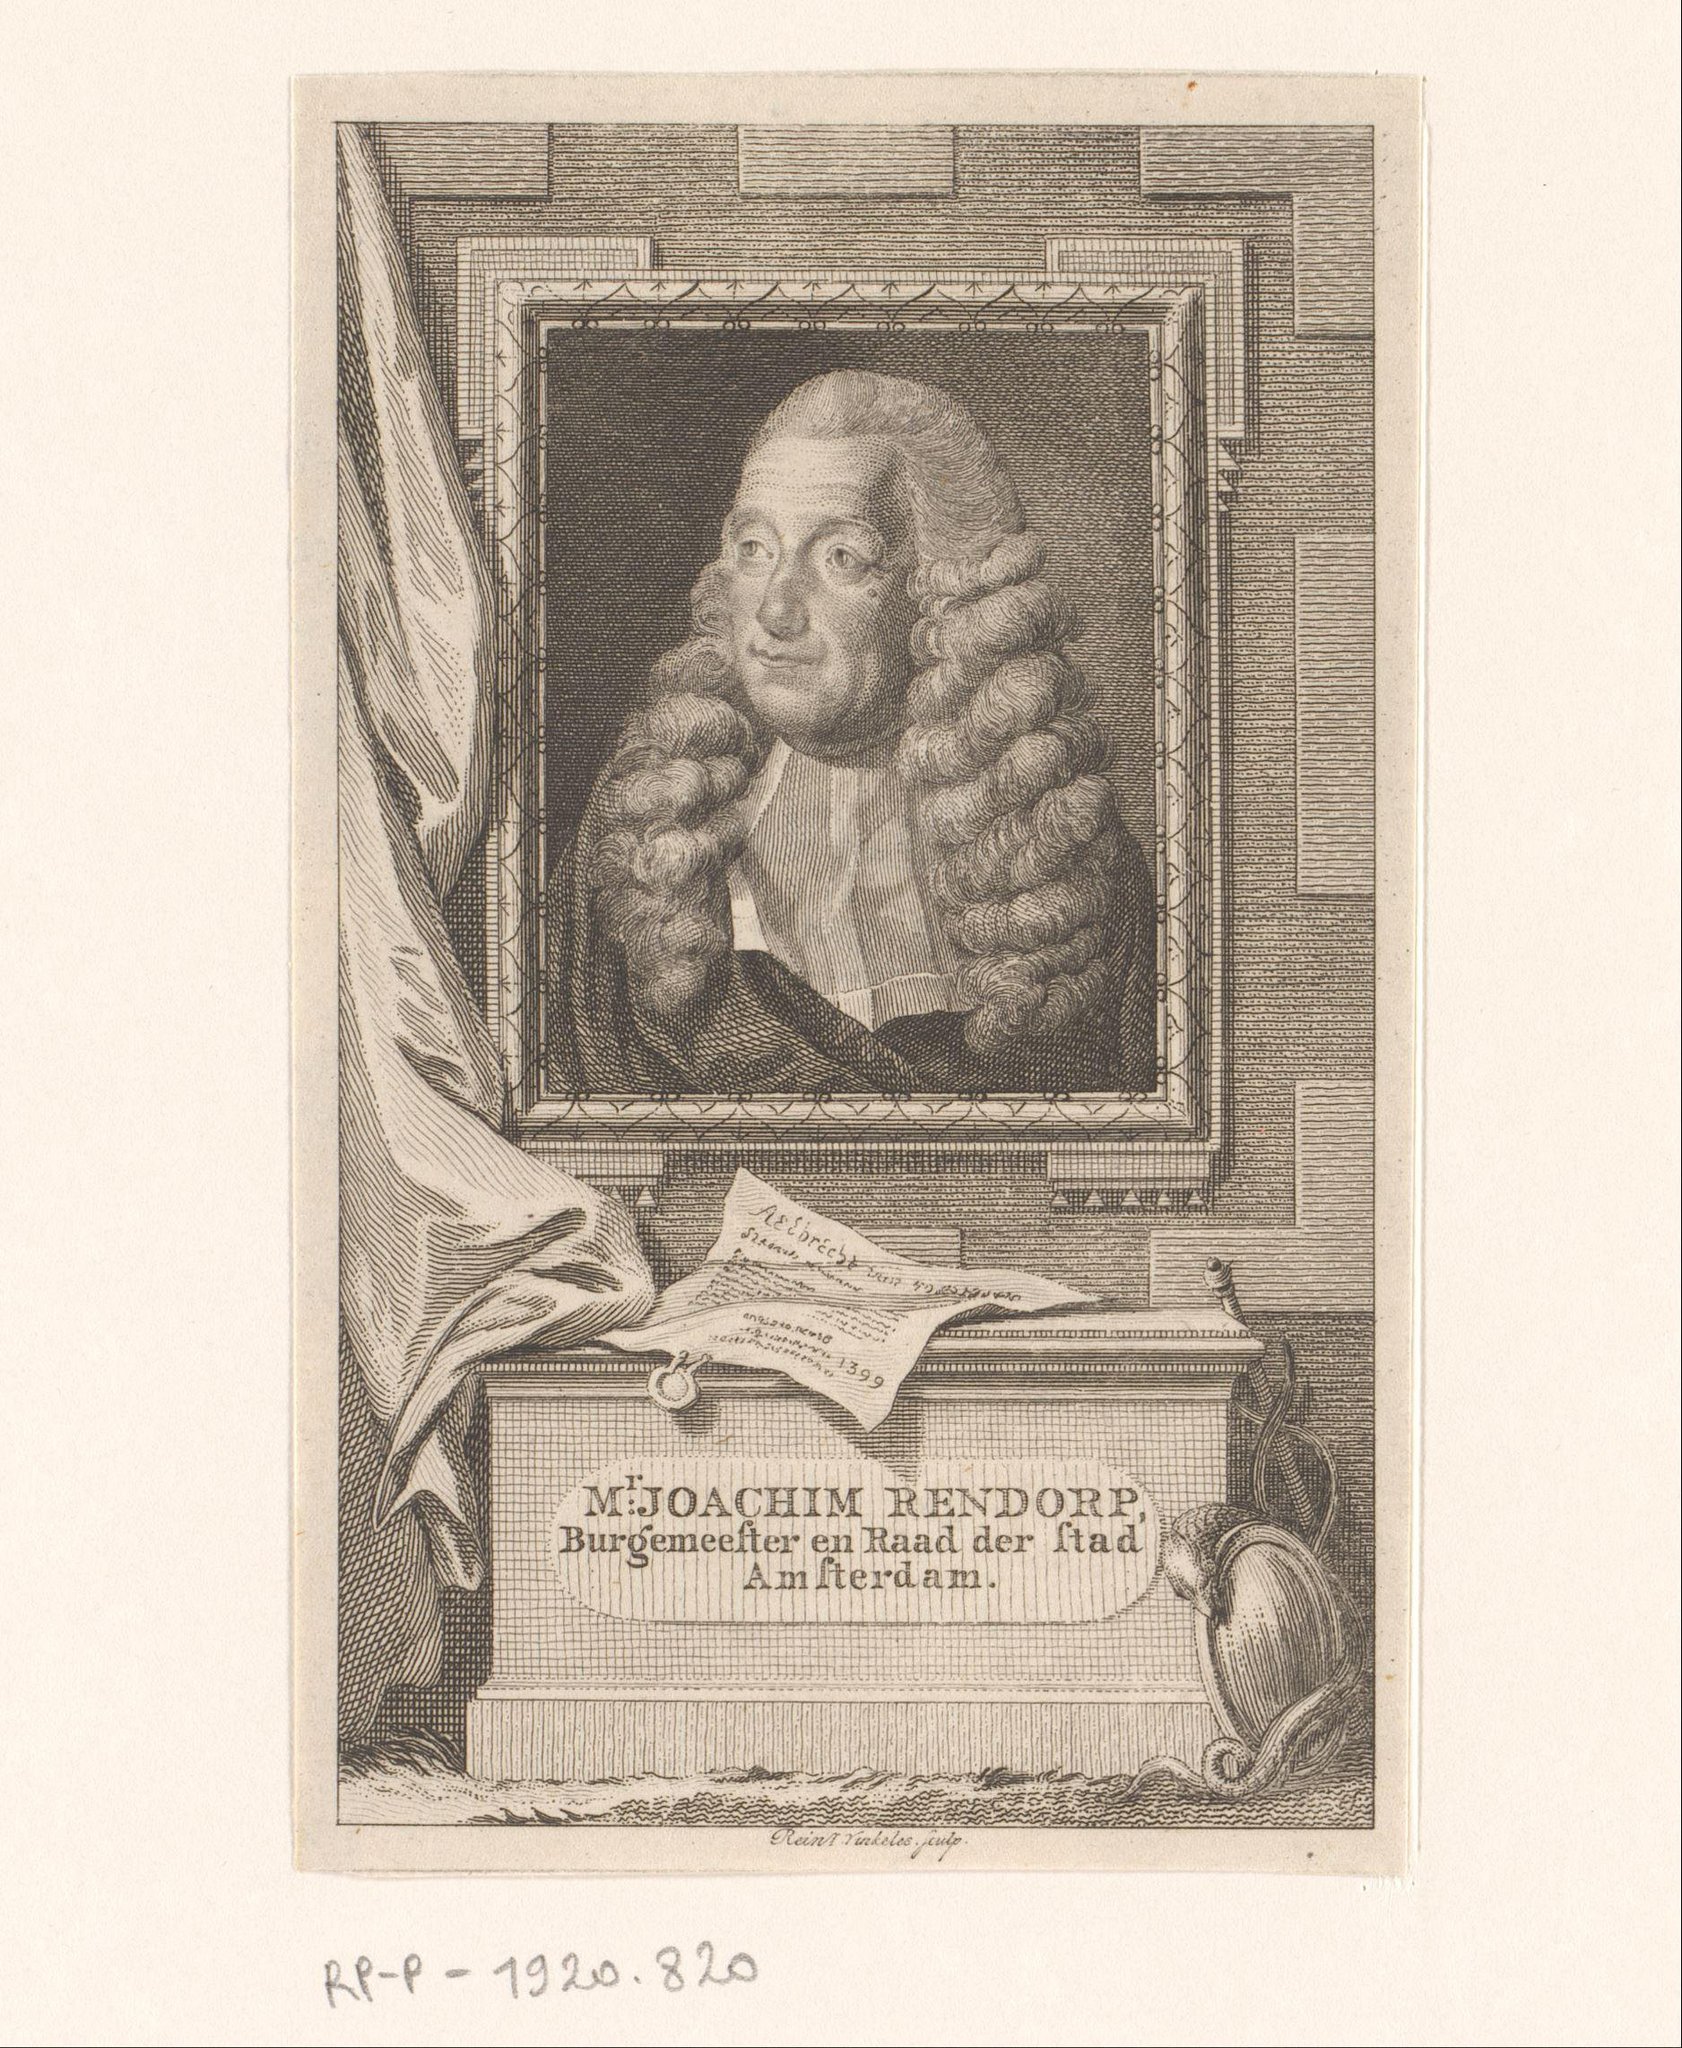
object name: print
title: Portret van Joachim Rendorp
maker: reinier vinkeles (i)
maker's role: draughtsman, print maker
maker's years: 1741-1816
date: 1800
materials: paper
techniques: etching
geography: amsterdam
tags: joachim rendorp, mayor, burgomaster, historical persons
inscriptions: collector's mark: Lugt 2228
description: Portret van de Amsterdamse burgemeester Joachim Rendorp. Onder het portret een document uit 1399 van Albrecht van Beieren, rechts een met een slang omkronkelde spiegel, symbool voor voorzichtigheid.